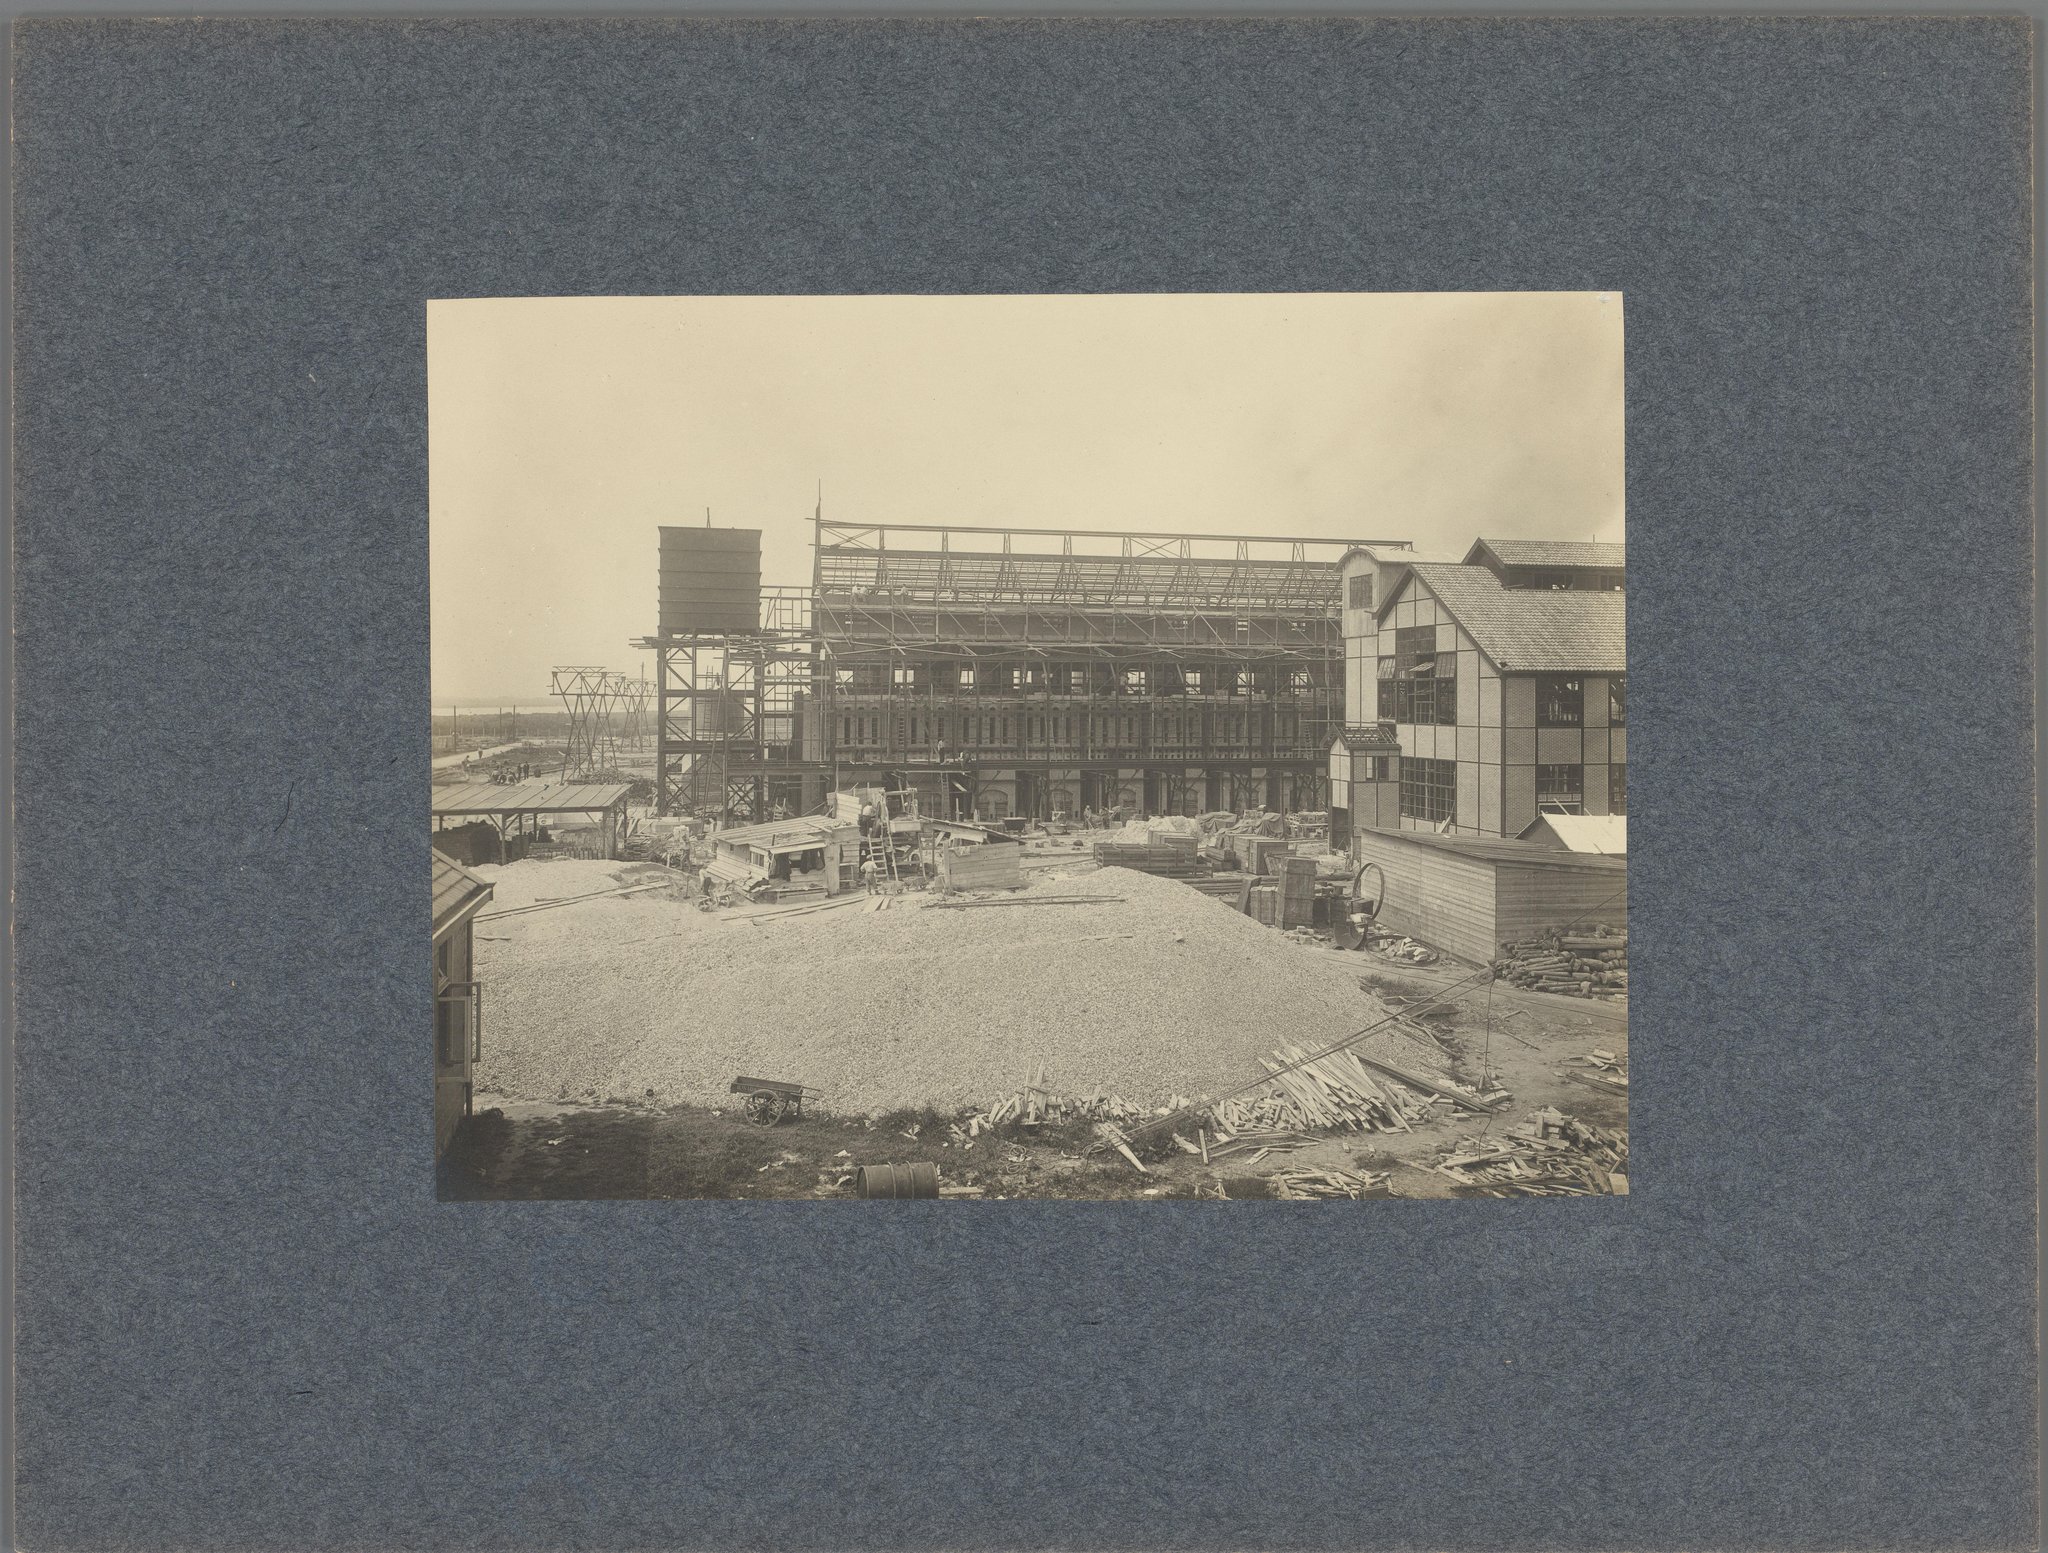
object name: photograph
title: Bouwplaats van de gasfabriek in de Keilehaven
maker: willem sr. bleuzé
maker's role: fotograaf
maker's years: 1873-1948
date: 1912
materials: paper, cardboard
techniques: gelatin silver print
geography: rotterdam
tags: factory-building, building-site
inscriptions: inscription: ‘25 juli 1912’, address: ‘W. BLEUZÉ/ ROTTERDAM/ JONKER FRANSSTRAAT 66’